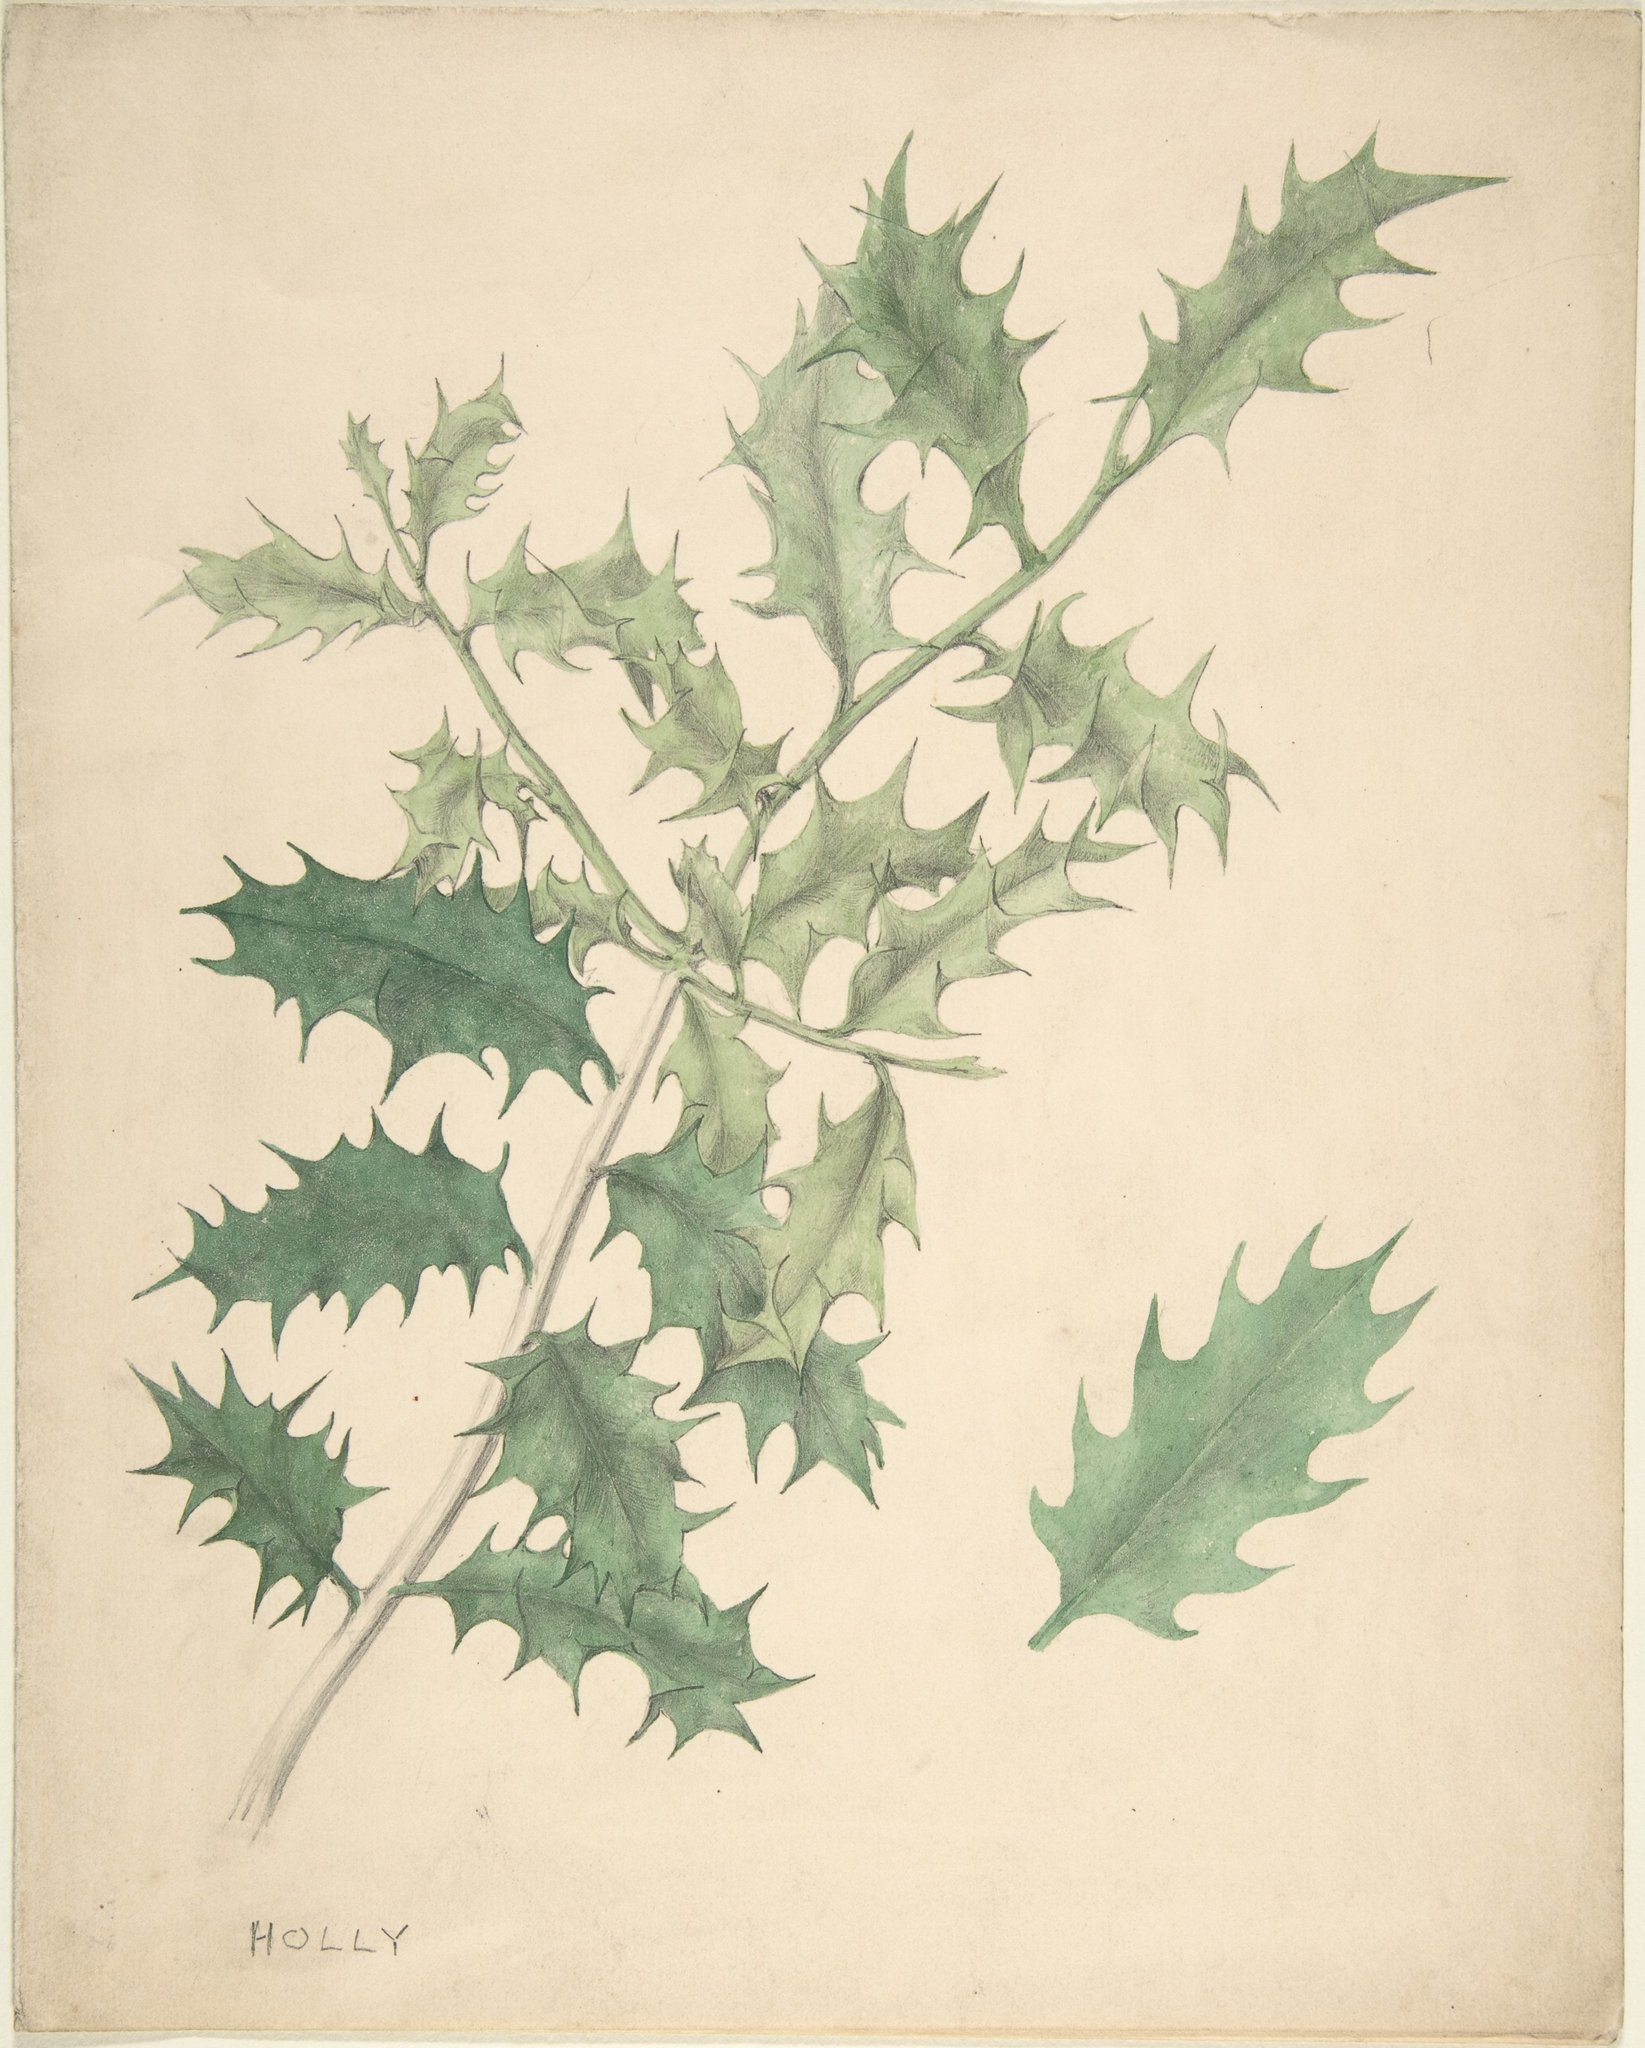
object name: drawing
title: Holly Leaves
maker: anonymous, british, 19th century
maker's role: artist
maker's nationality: british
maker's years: 1800-1900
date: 1801-1900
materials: watercolor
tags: leaves